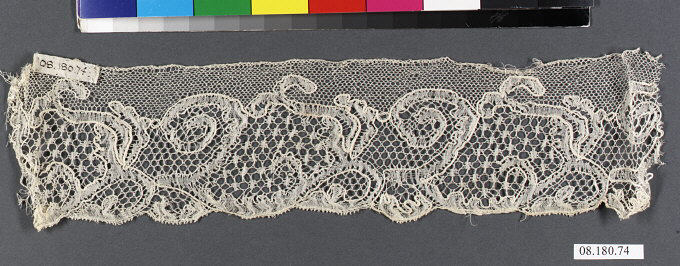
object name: fragment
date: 1801-1900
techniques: lace